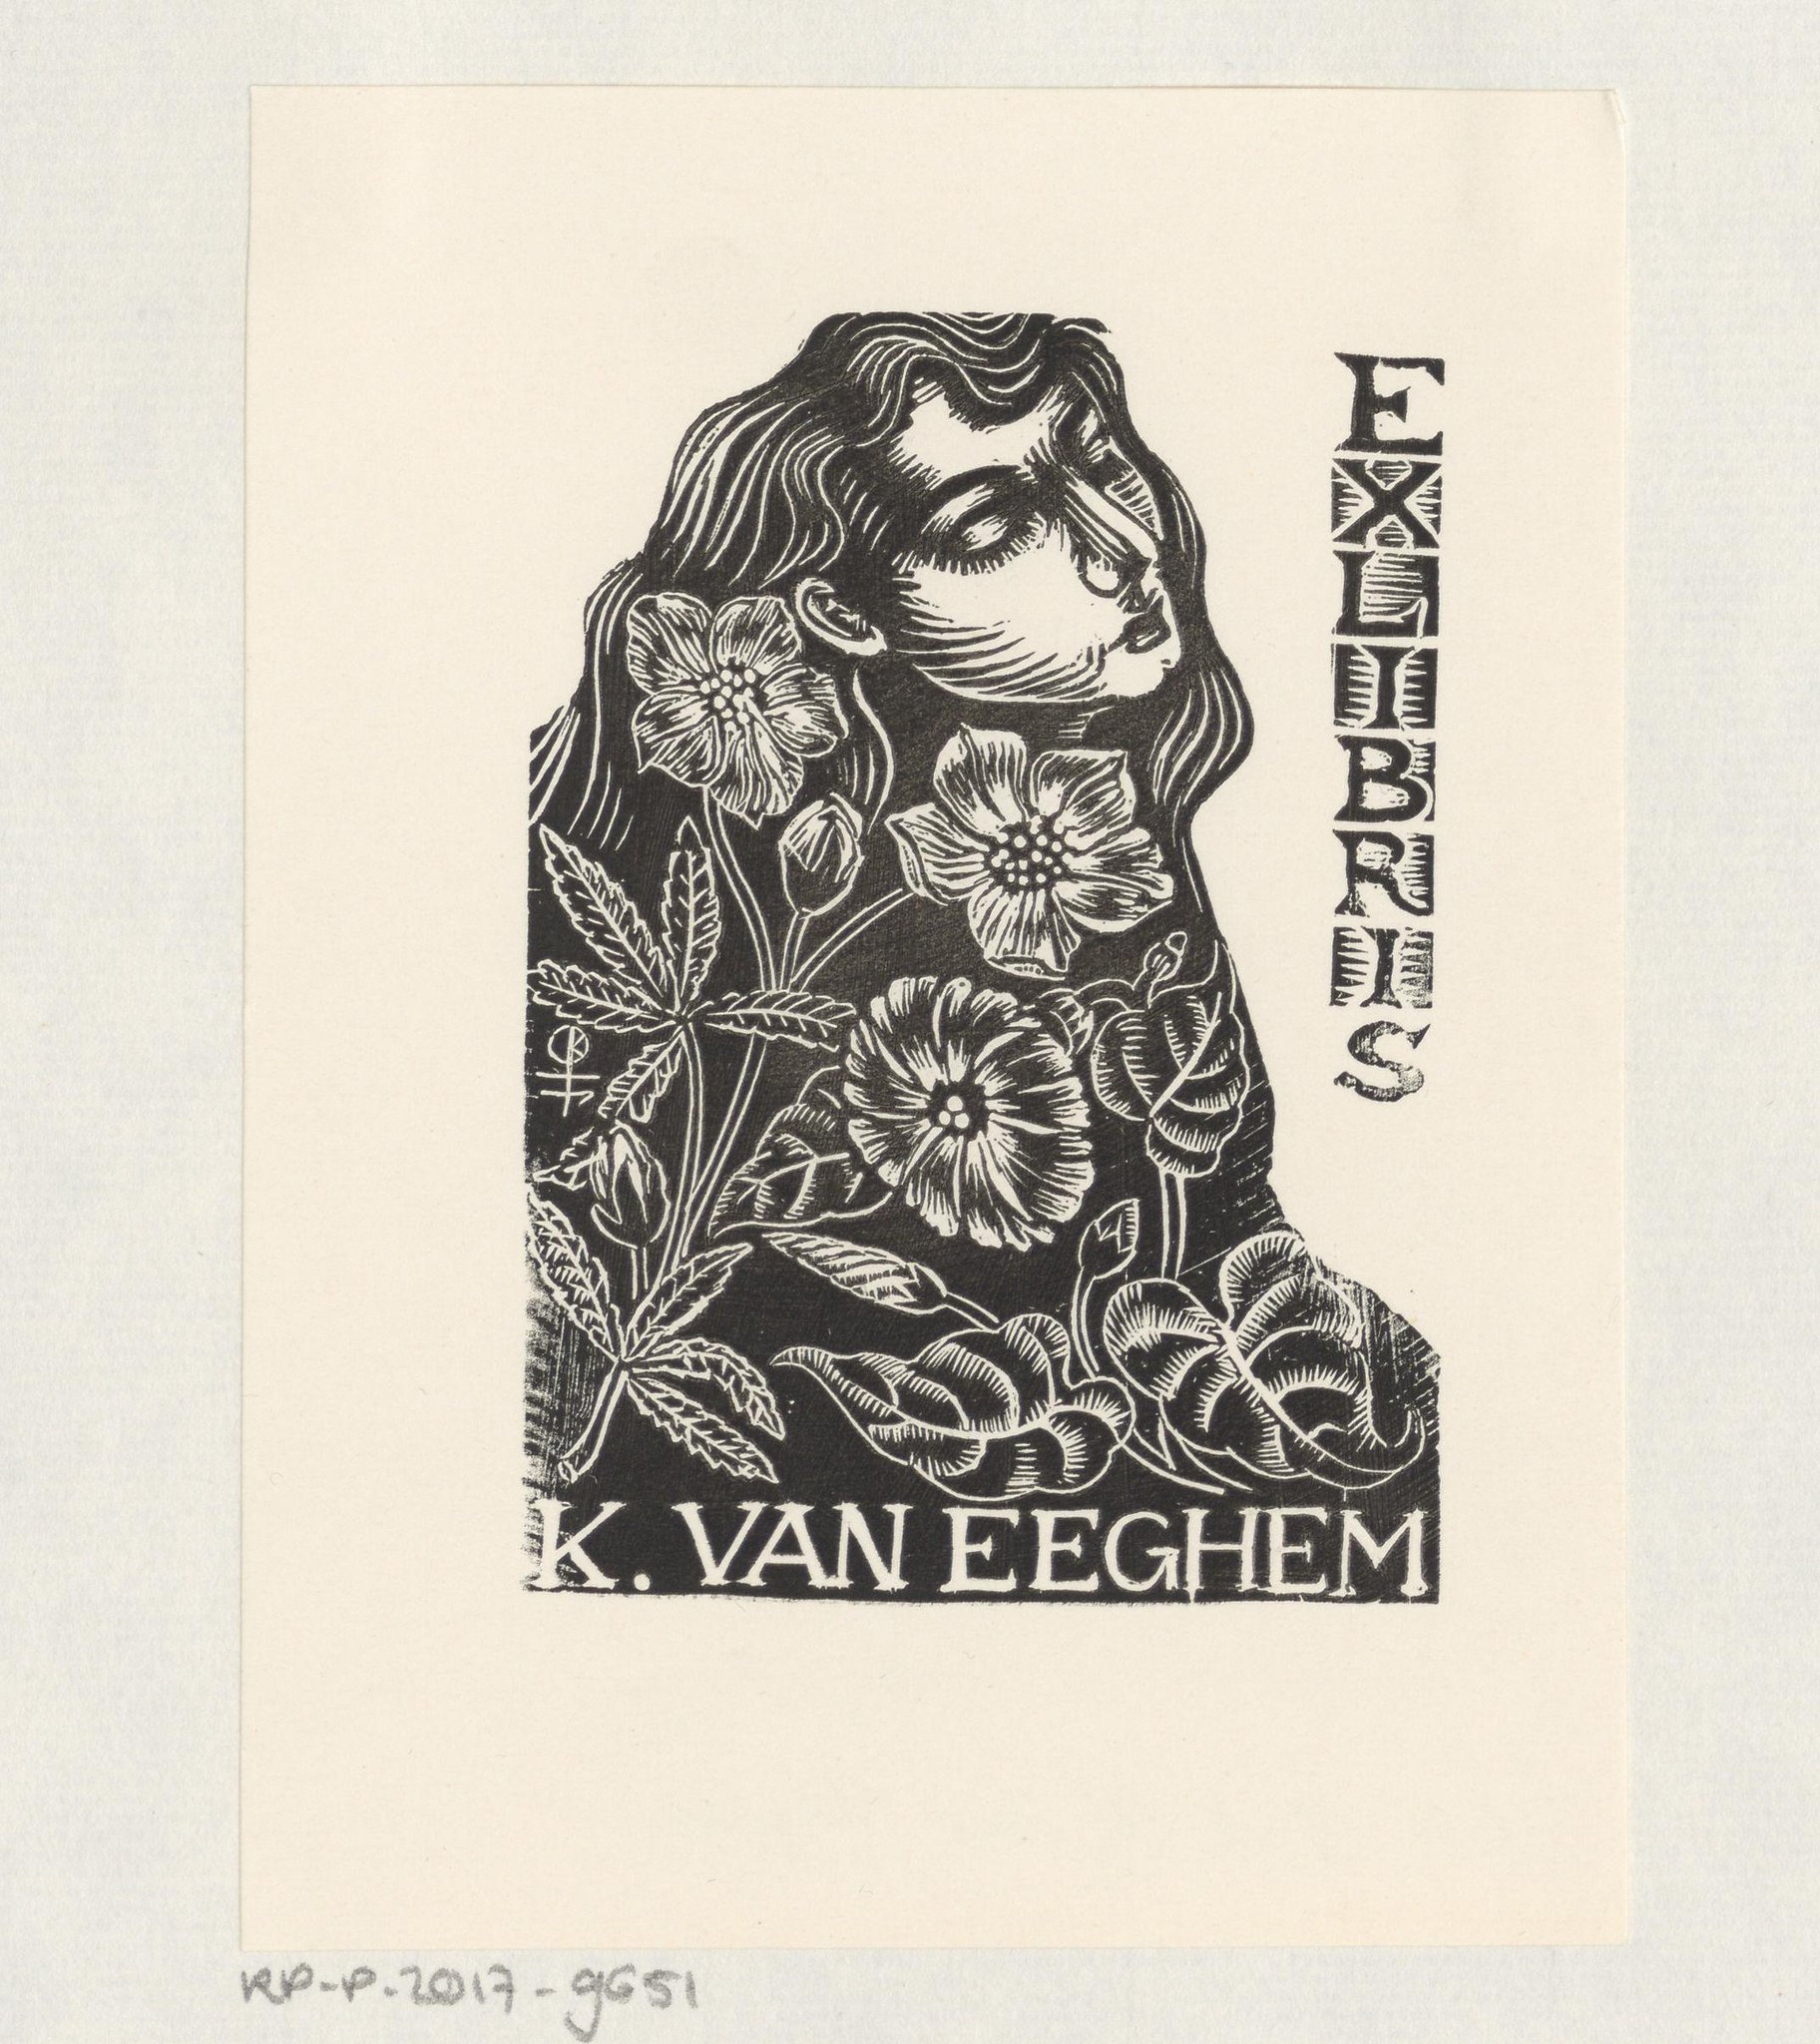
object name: bookplate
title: Ex libris van Karel van Eeghem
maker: karel van eeghem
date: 1959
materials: paper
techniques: woodcut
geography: belgium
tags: karel van eeghem, flowers, head (human) - aa - female human figure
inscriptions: inscription: ‘X. 2 1959 K. van Eeghem’